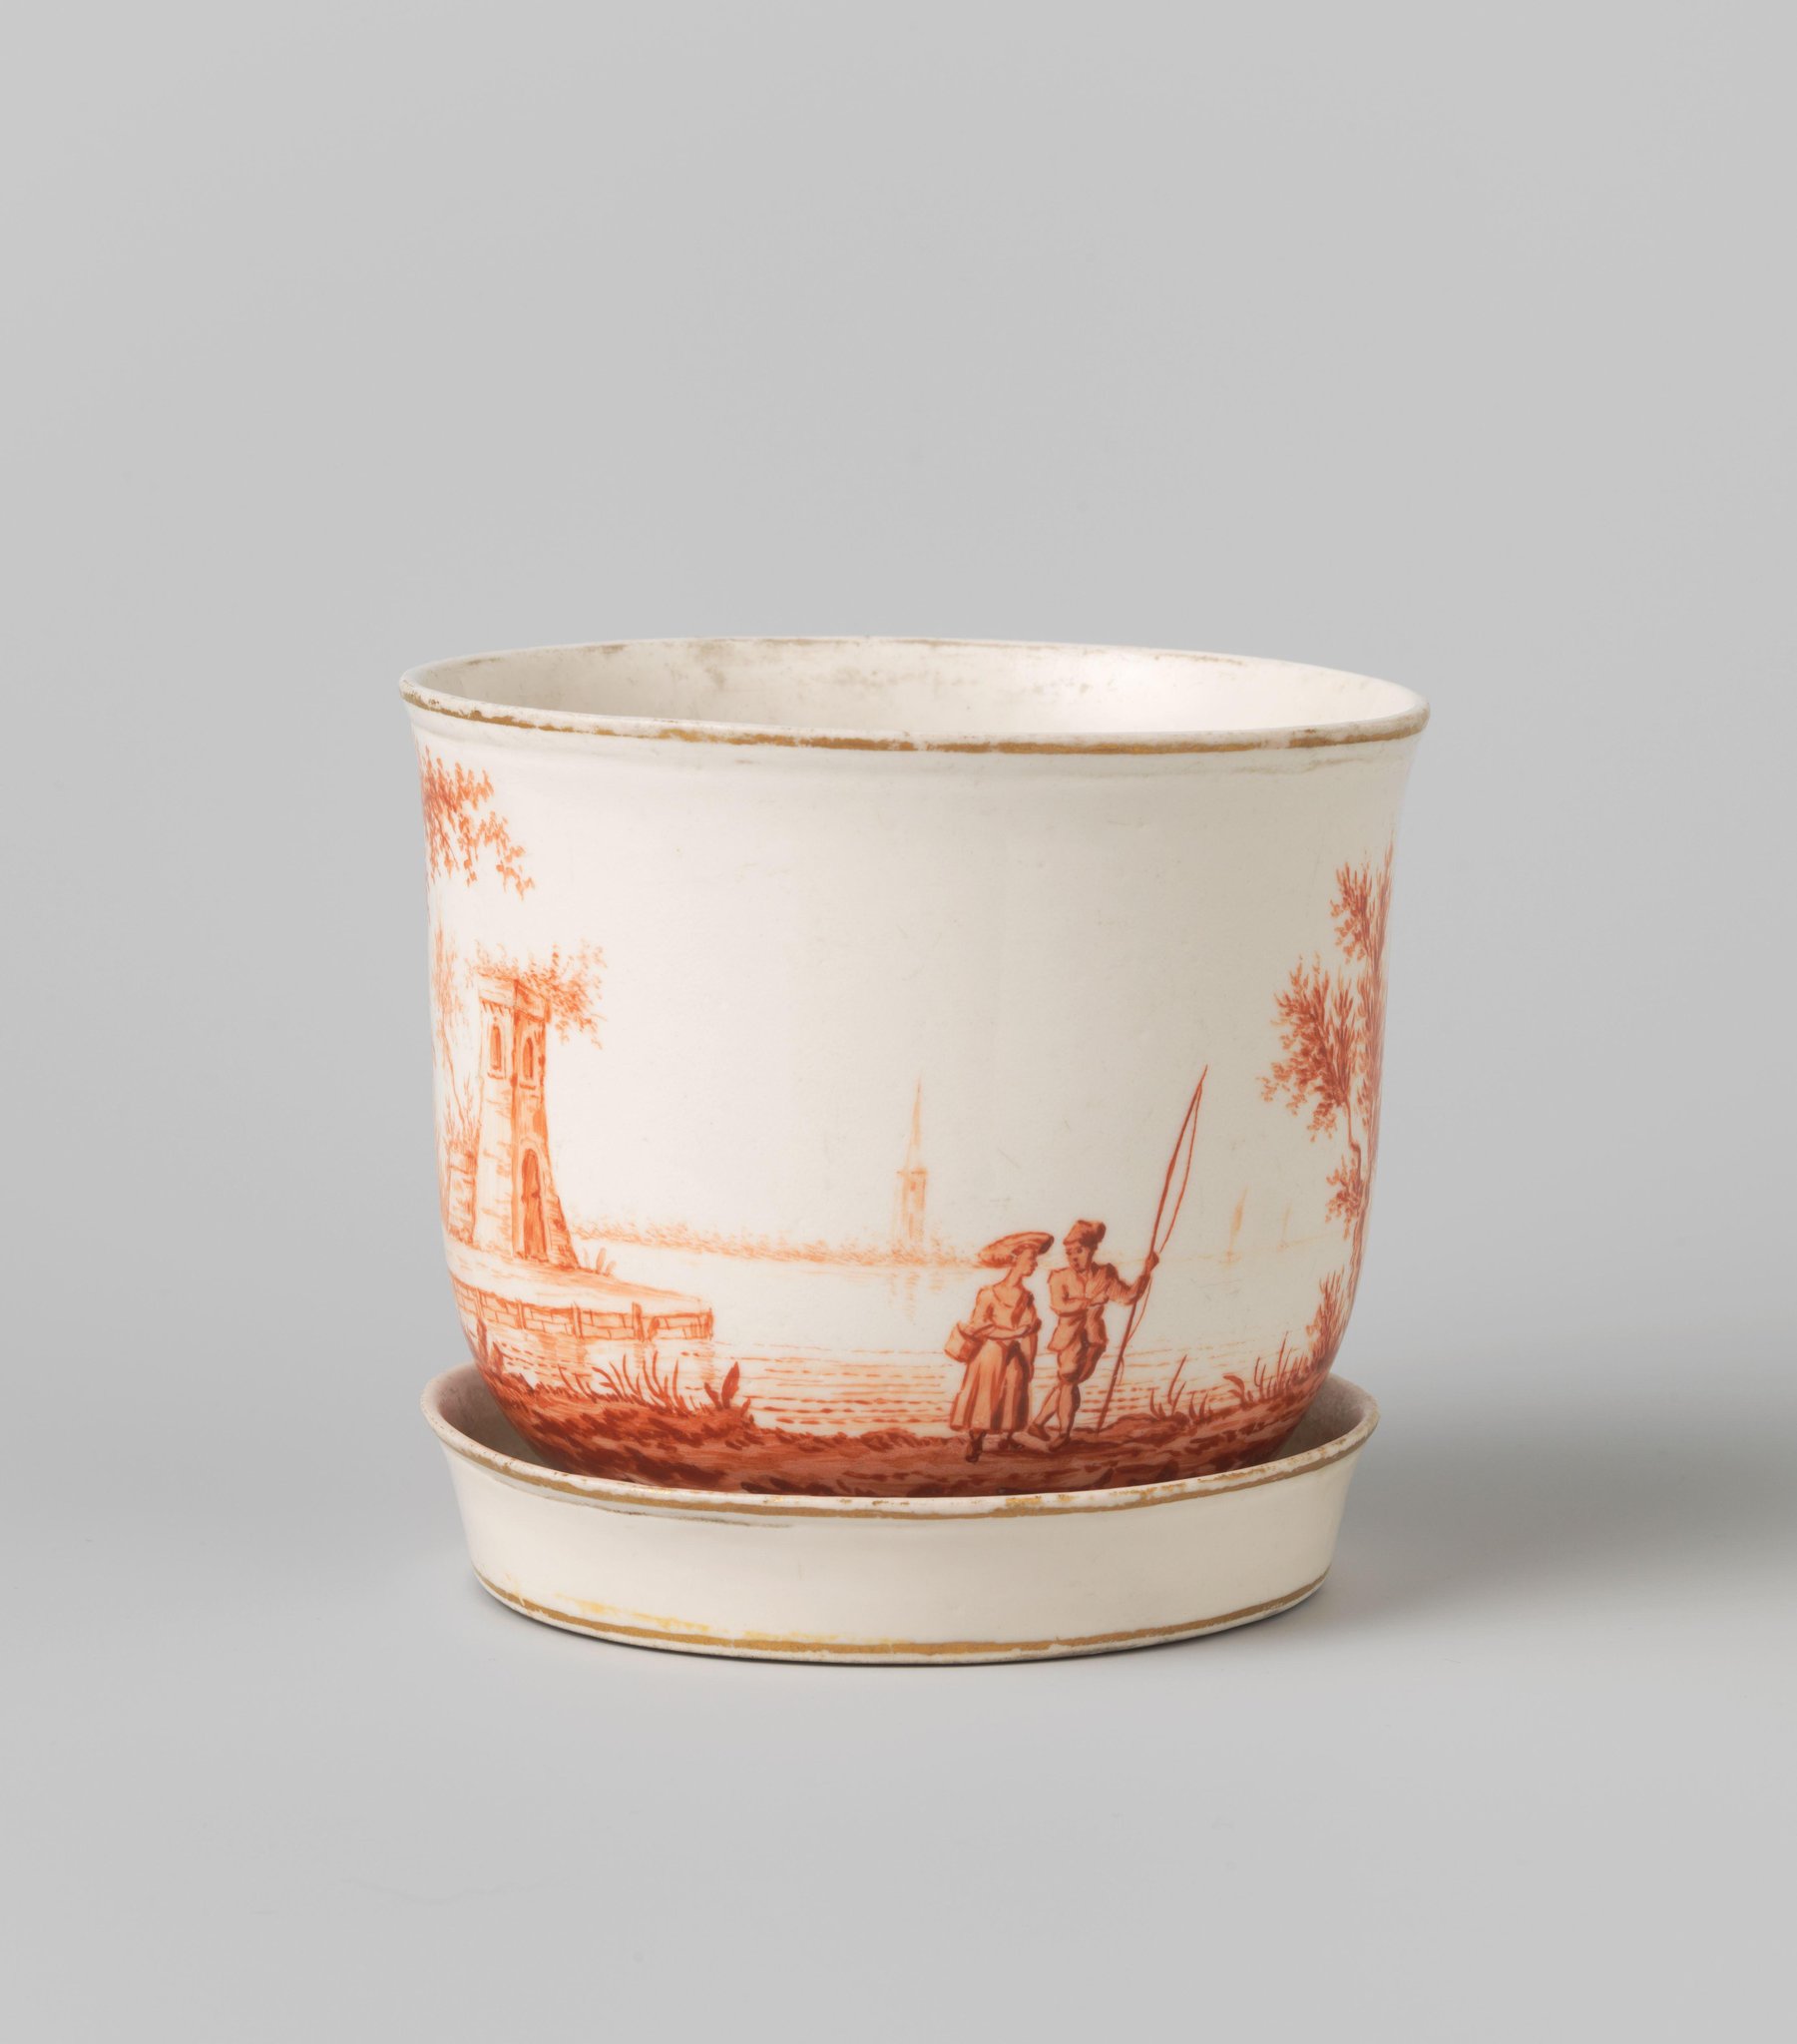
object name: flowerpot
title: Onderschotel van porselein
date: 1774-1784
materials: porcelain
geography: loosdrecht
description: Op de onderschotel een landschap met toren.